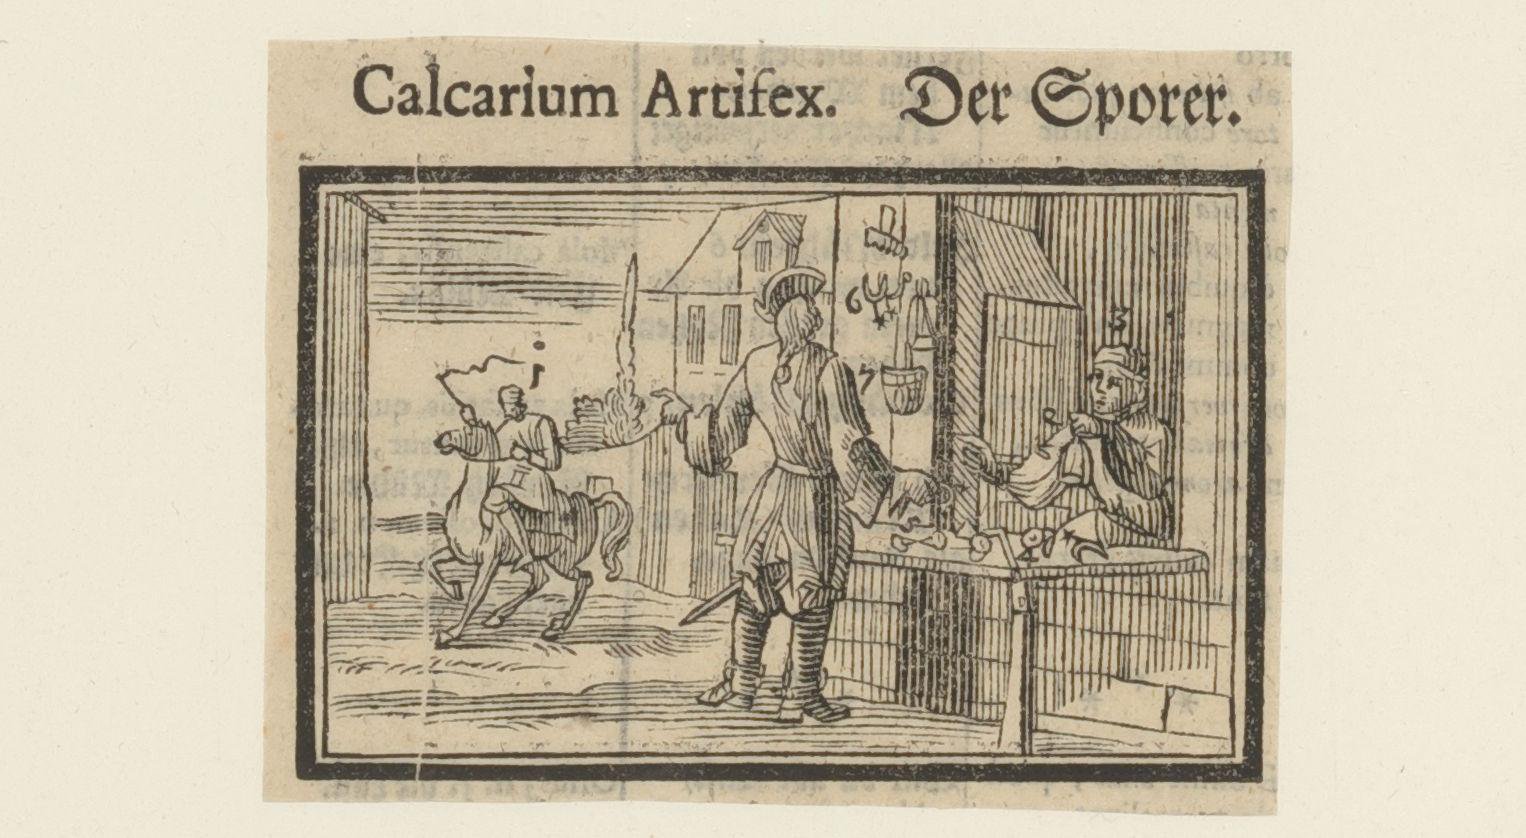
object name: print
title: Sporensmid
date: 1719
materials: paper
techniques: letterpress printing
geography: nuremberg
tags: handicrafts, craftsman at work, smith, blacksmith, horseshoe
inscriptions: stamp, collector's mark: Lugt 1641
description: Prent uit: Comenius, Johannes Amosius. Orbis sensualium picti pars prima (...). Neurenberg: Martin Endter, 1719, dl. 2, p. 160. Prent eerder gebruikt in: Comenius, Johannes Amosius. Orbis Sensualium Picti denuo aucti Pars Secunda (...). Neurenberg: Martin Endter, 1730, dl. 2.